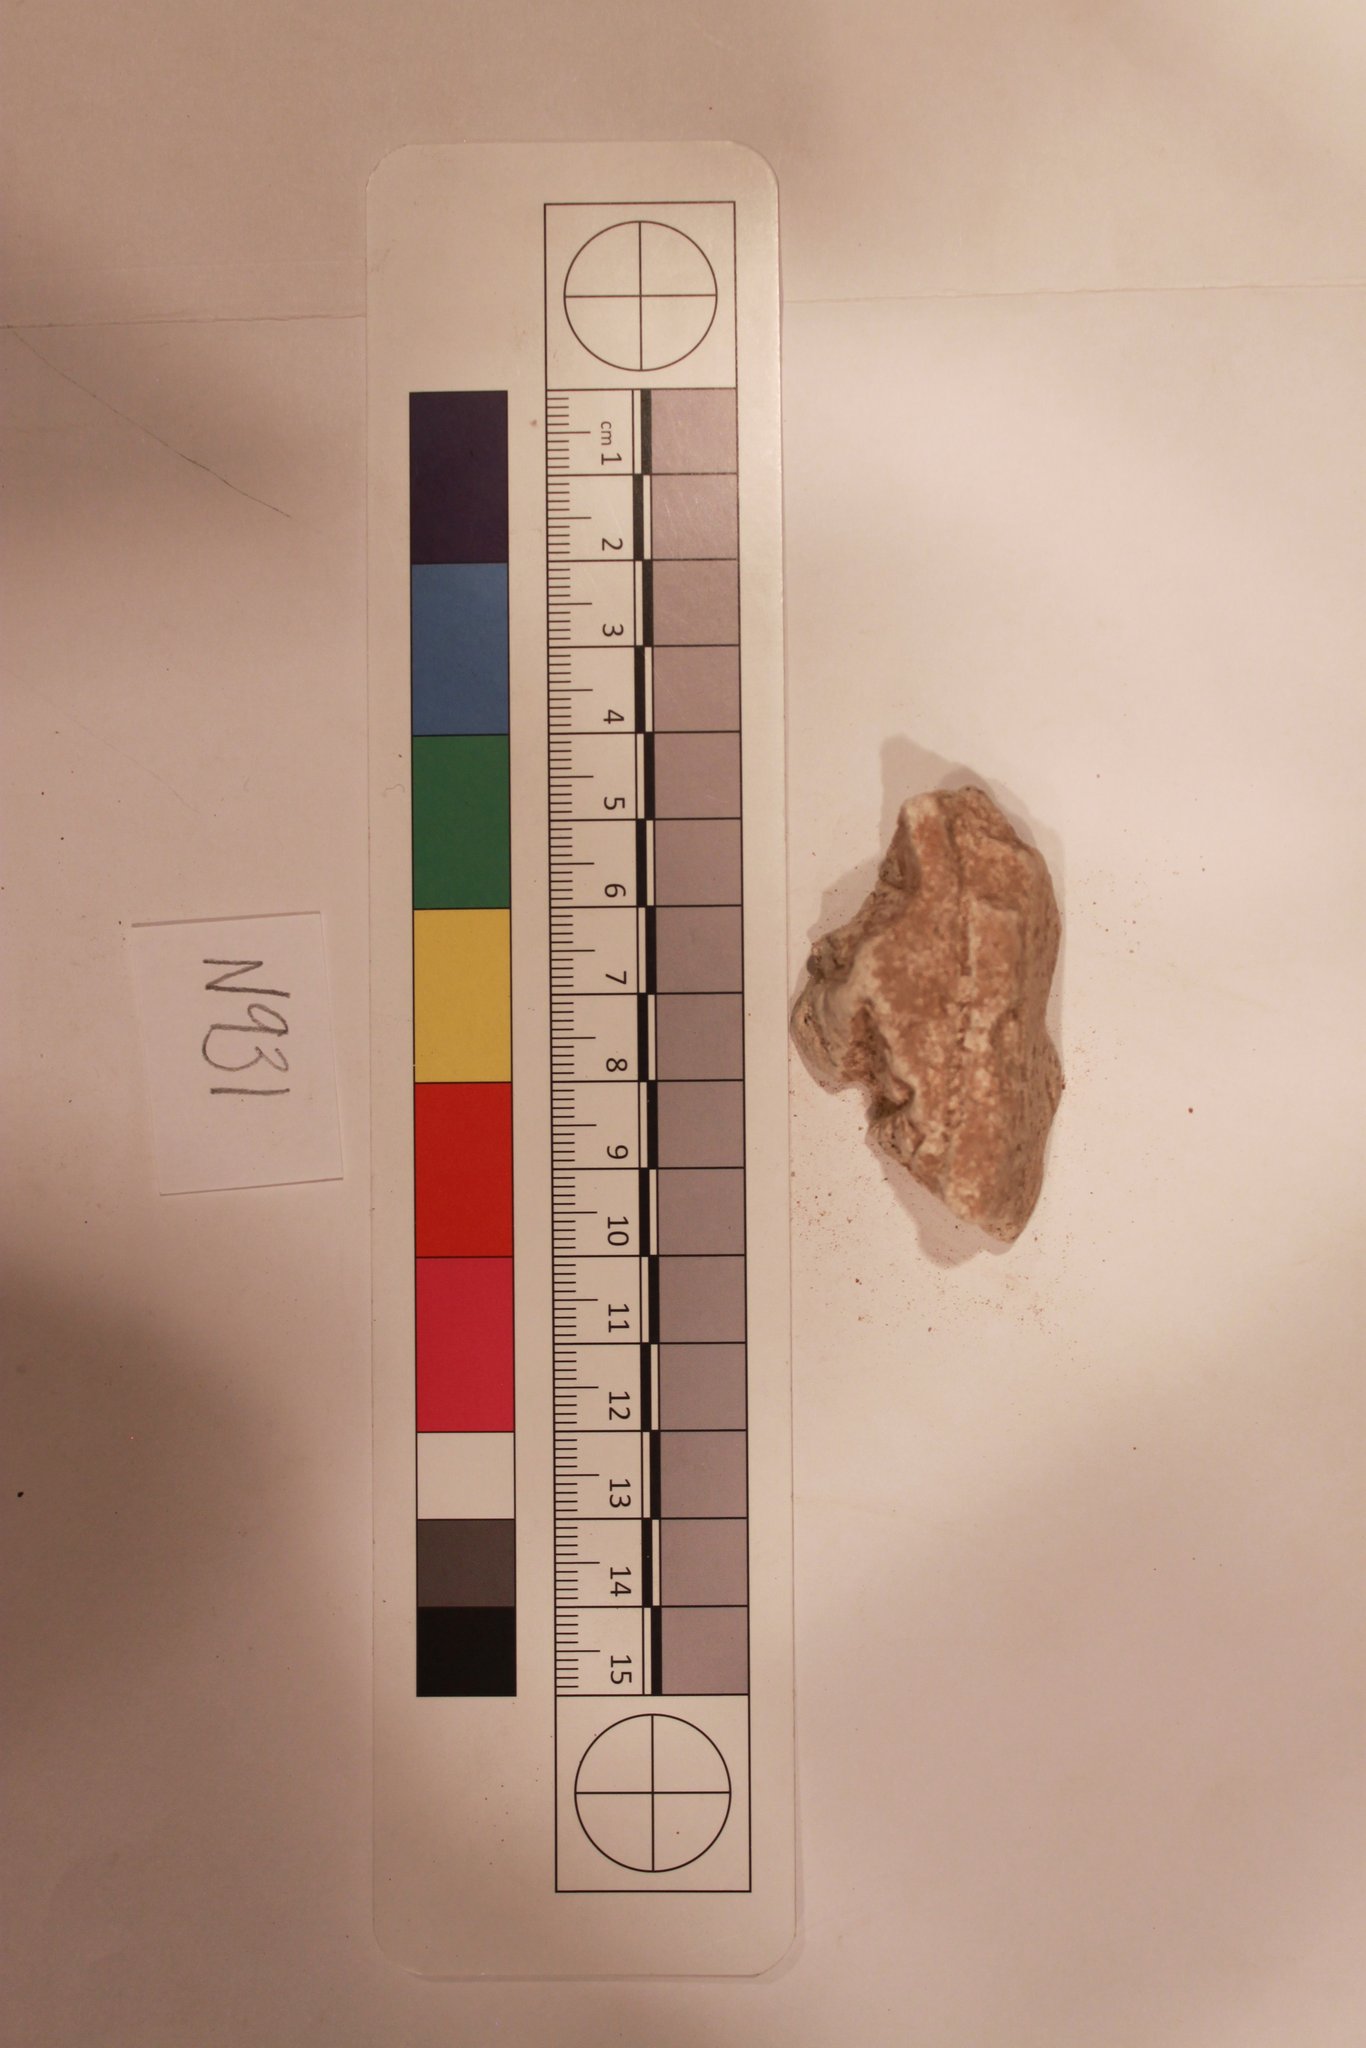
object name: fragment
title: Stucco Fragment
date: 701-1200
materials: plaster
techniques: carving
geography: iran